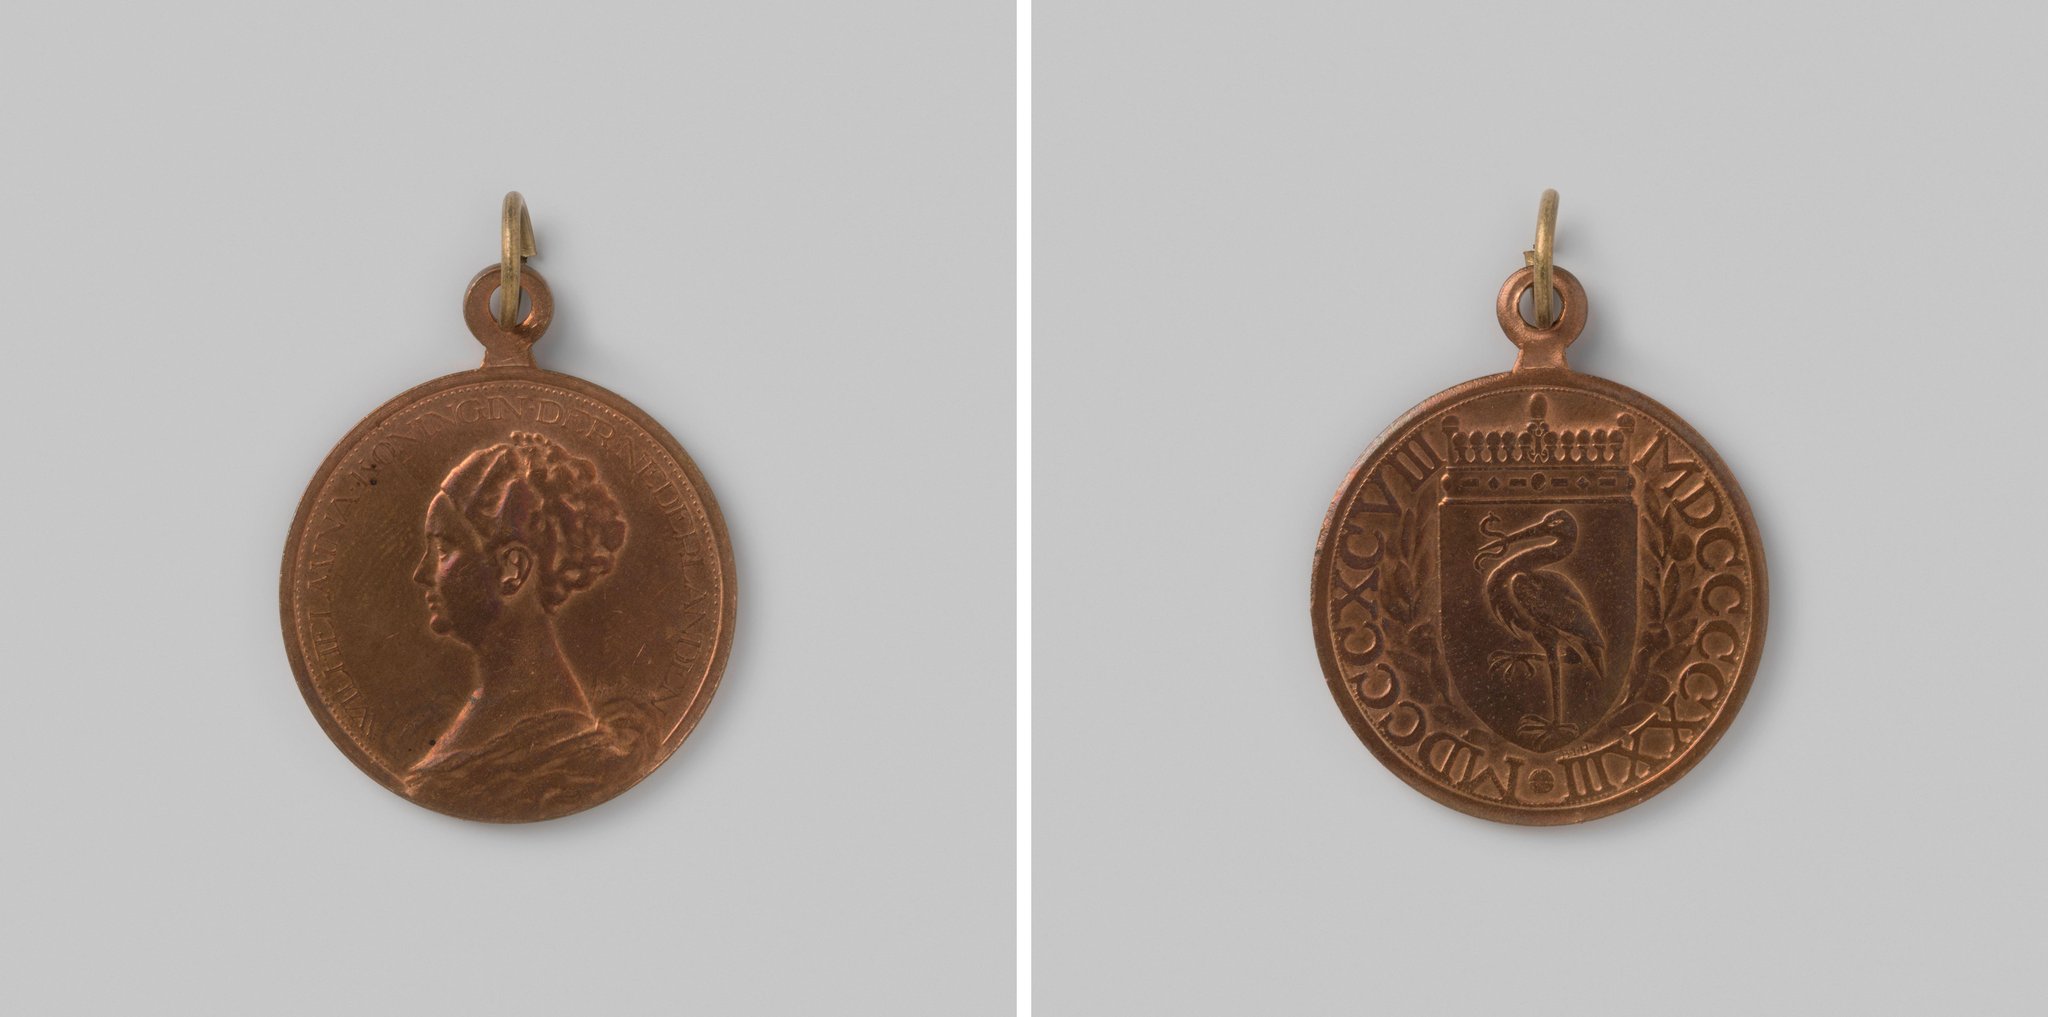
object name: history medal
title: Wilhelmina 25 jaar koningin der Nederlanden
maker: Anonymous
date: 1923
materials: copper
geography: the hague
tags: print maker, wilhelmina of the netherlands, netherlands, the hague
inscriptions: circumscription: ‘WILHELMINA KONINGIN DER NEDERLANDEN’, circumscription: ‘MDCCCXCVIII / MDCCCCXXIII’